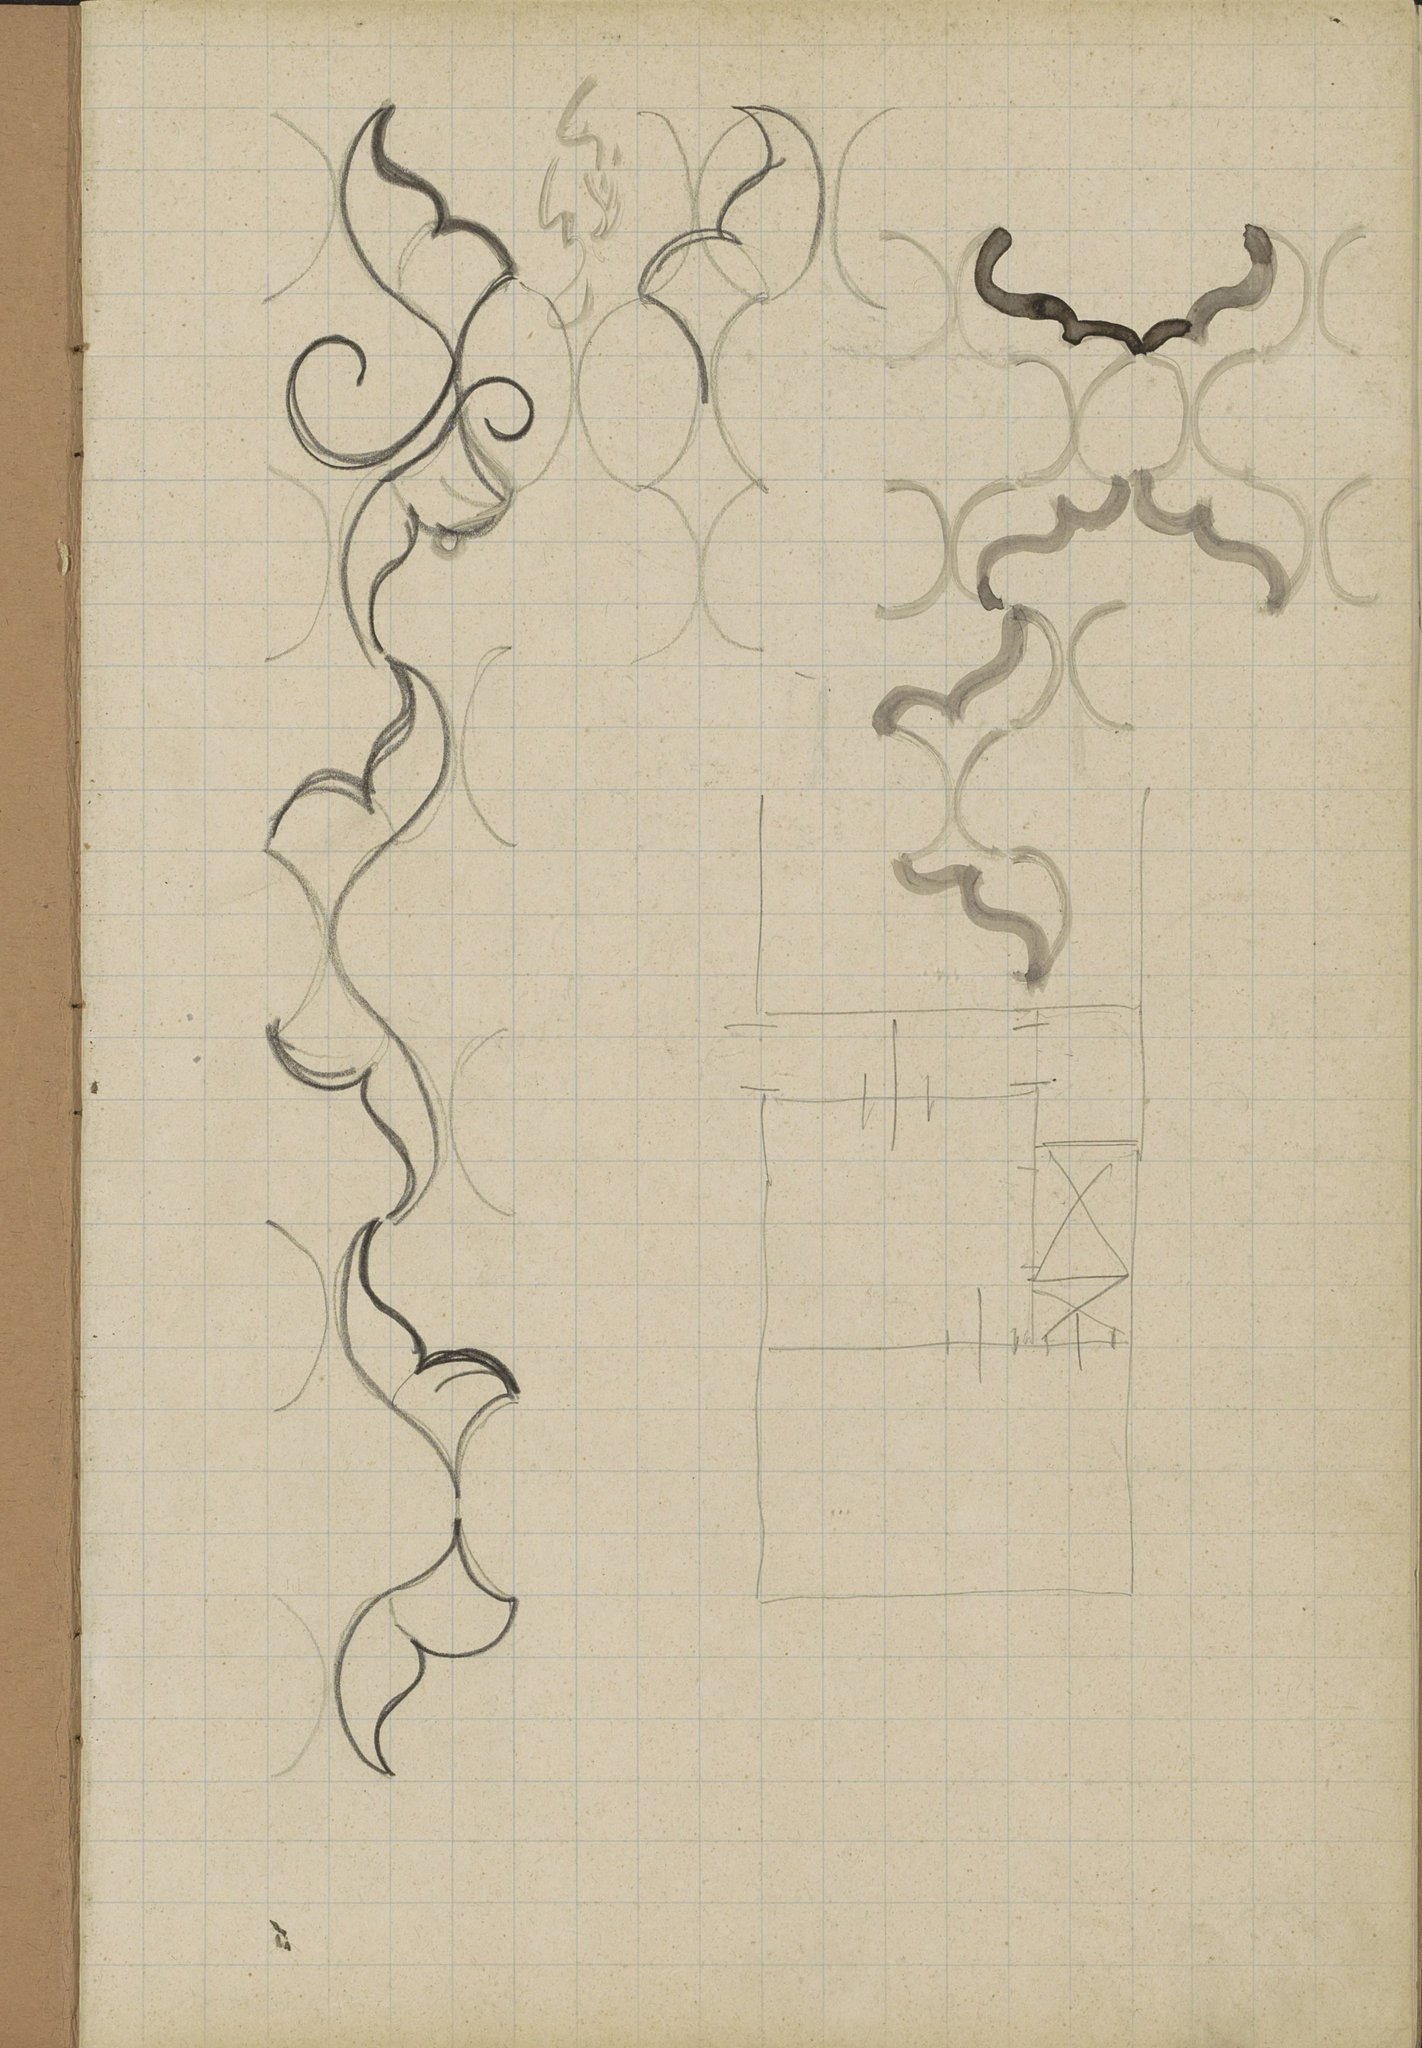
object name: sketchbook leaf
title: Ornamenten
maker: carel adolph lion cachet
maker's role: draughtsman, print maker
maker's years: 1864-1945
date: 1925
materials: pencil, watercolor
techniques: brush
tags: ornaments ~ art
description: Blad 1 recto uit een schetsboek met 11 bladen.